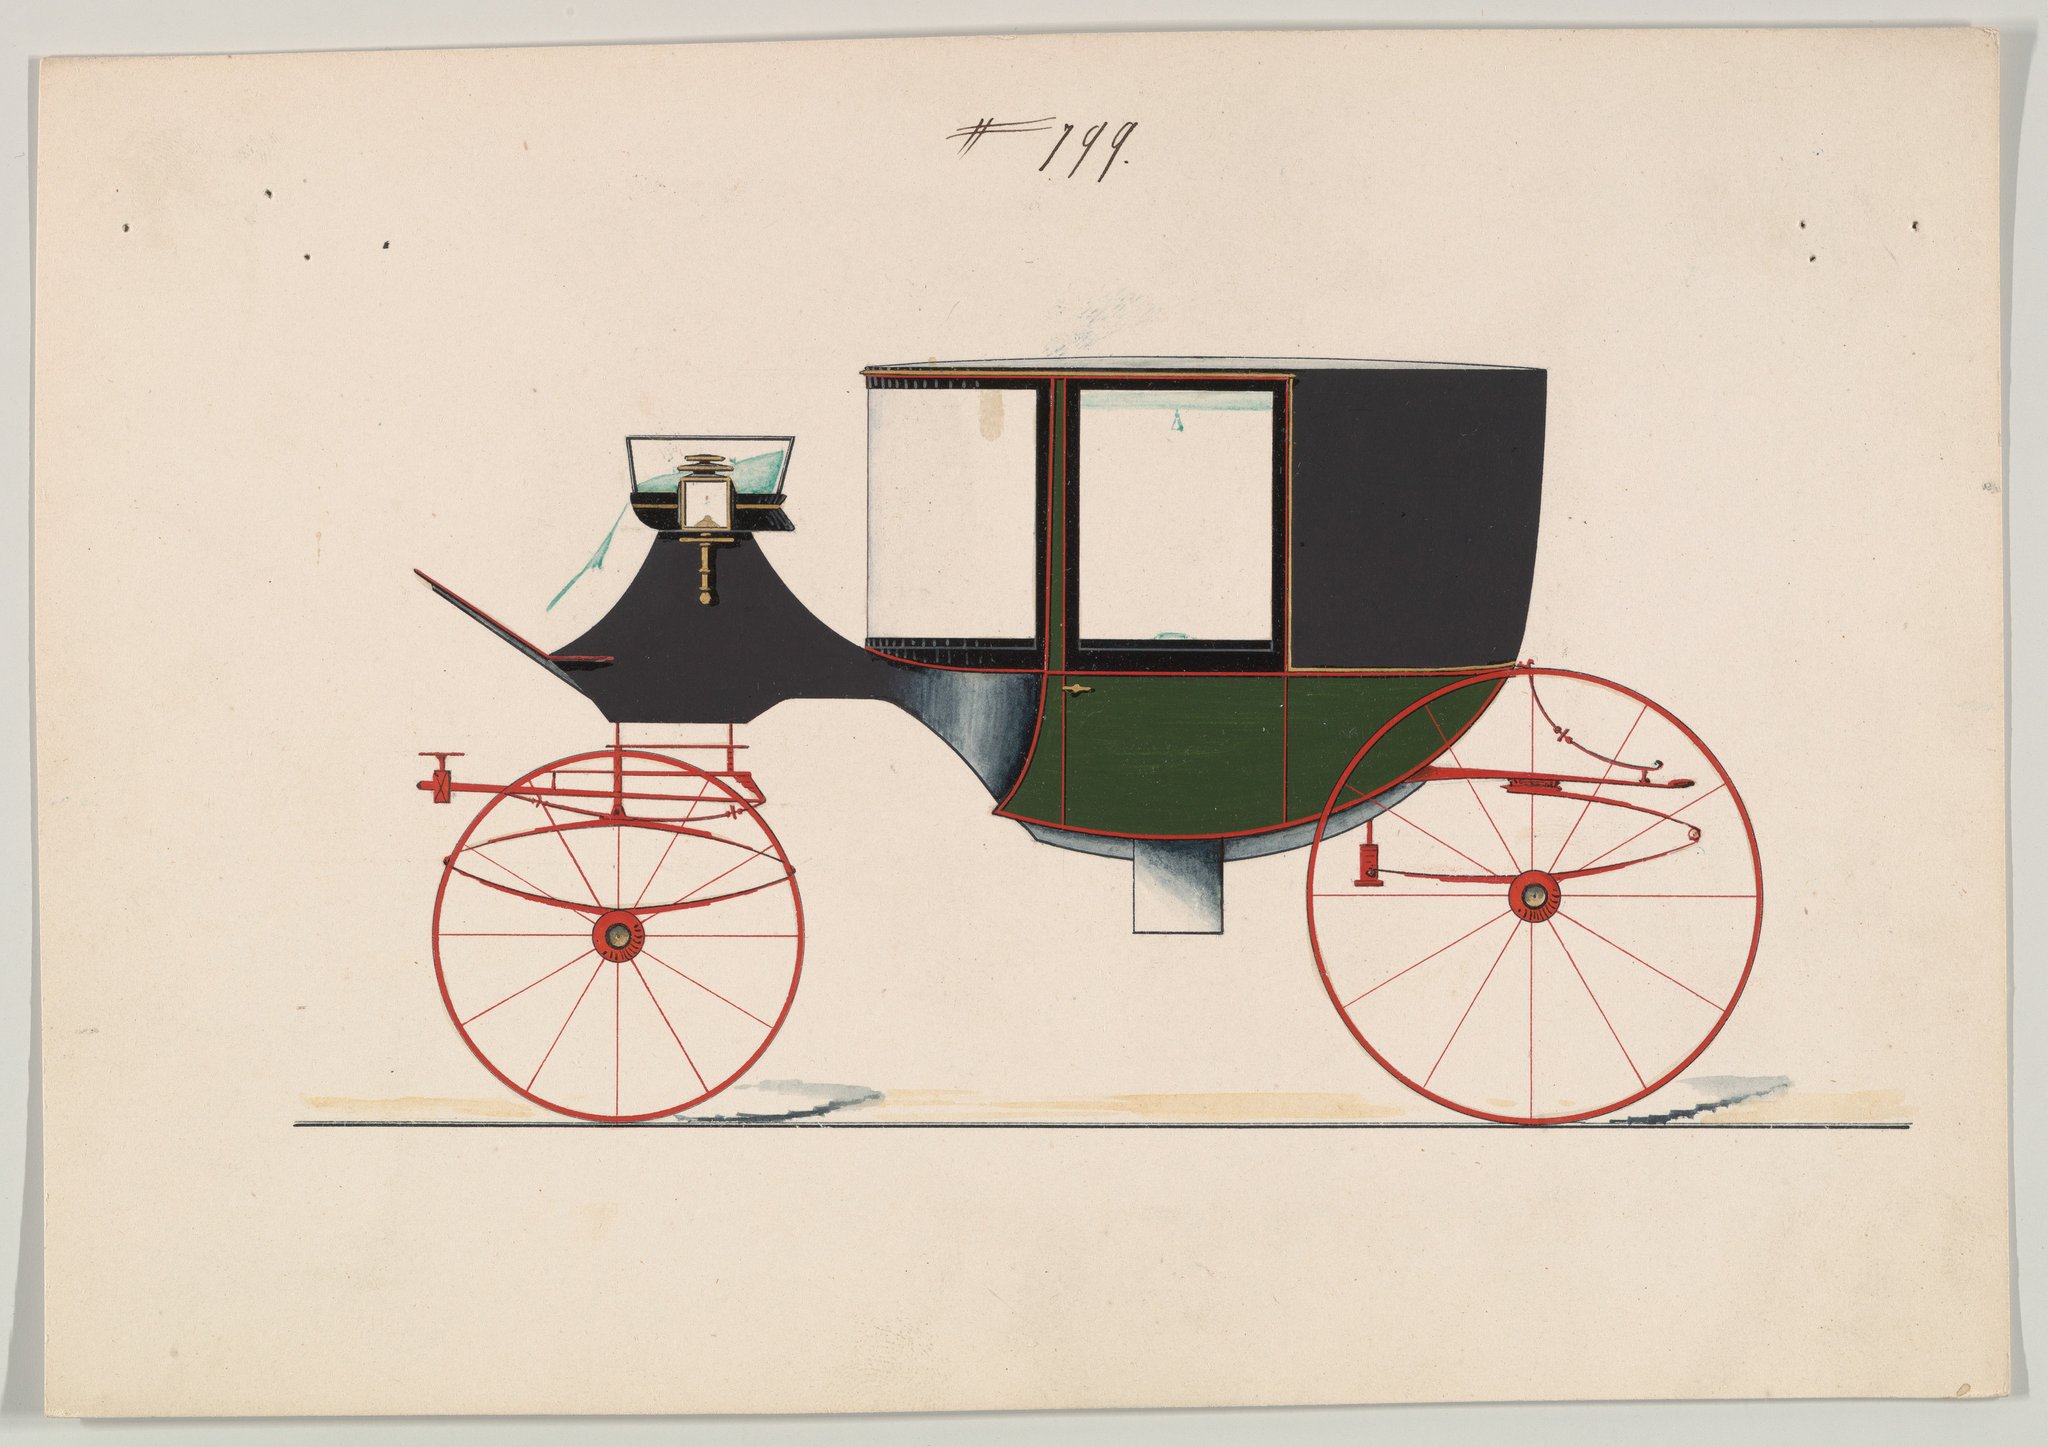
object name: drawing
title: Clarence # 799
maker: brewster & co.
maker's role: manufacturer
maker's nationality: american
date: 1850-1870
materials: gouache, gum arabic, ink, watercolor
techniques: pen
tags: carriages